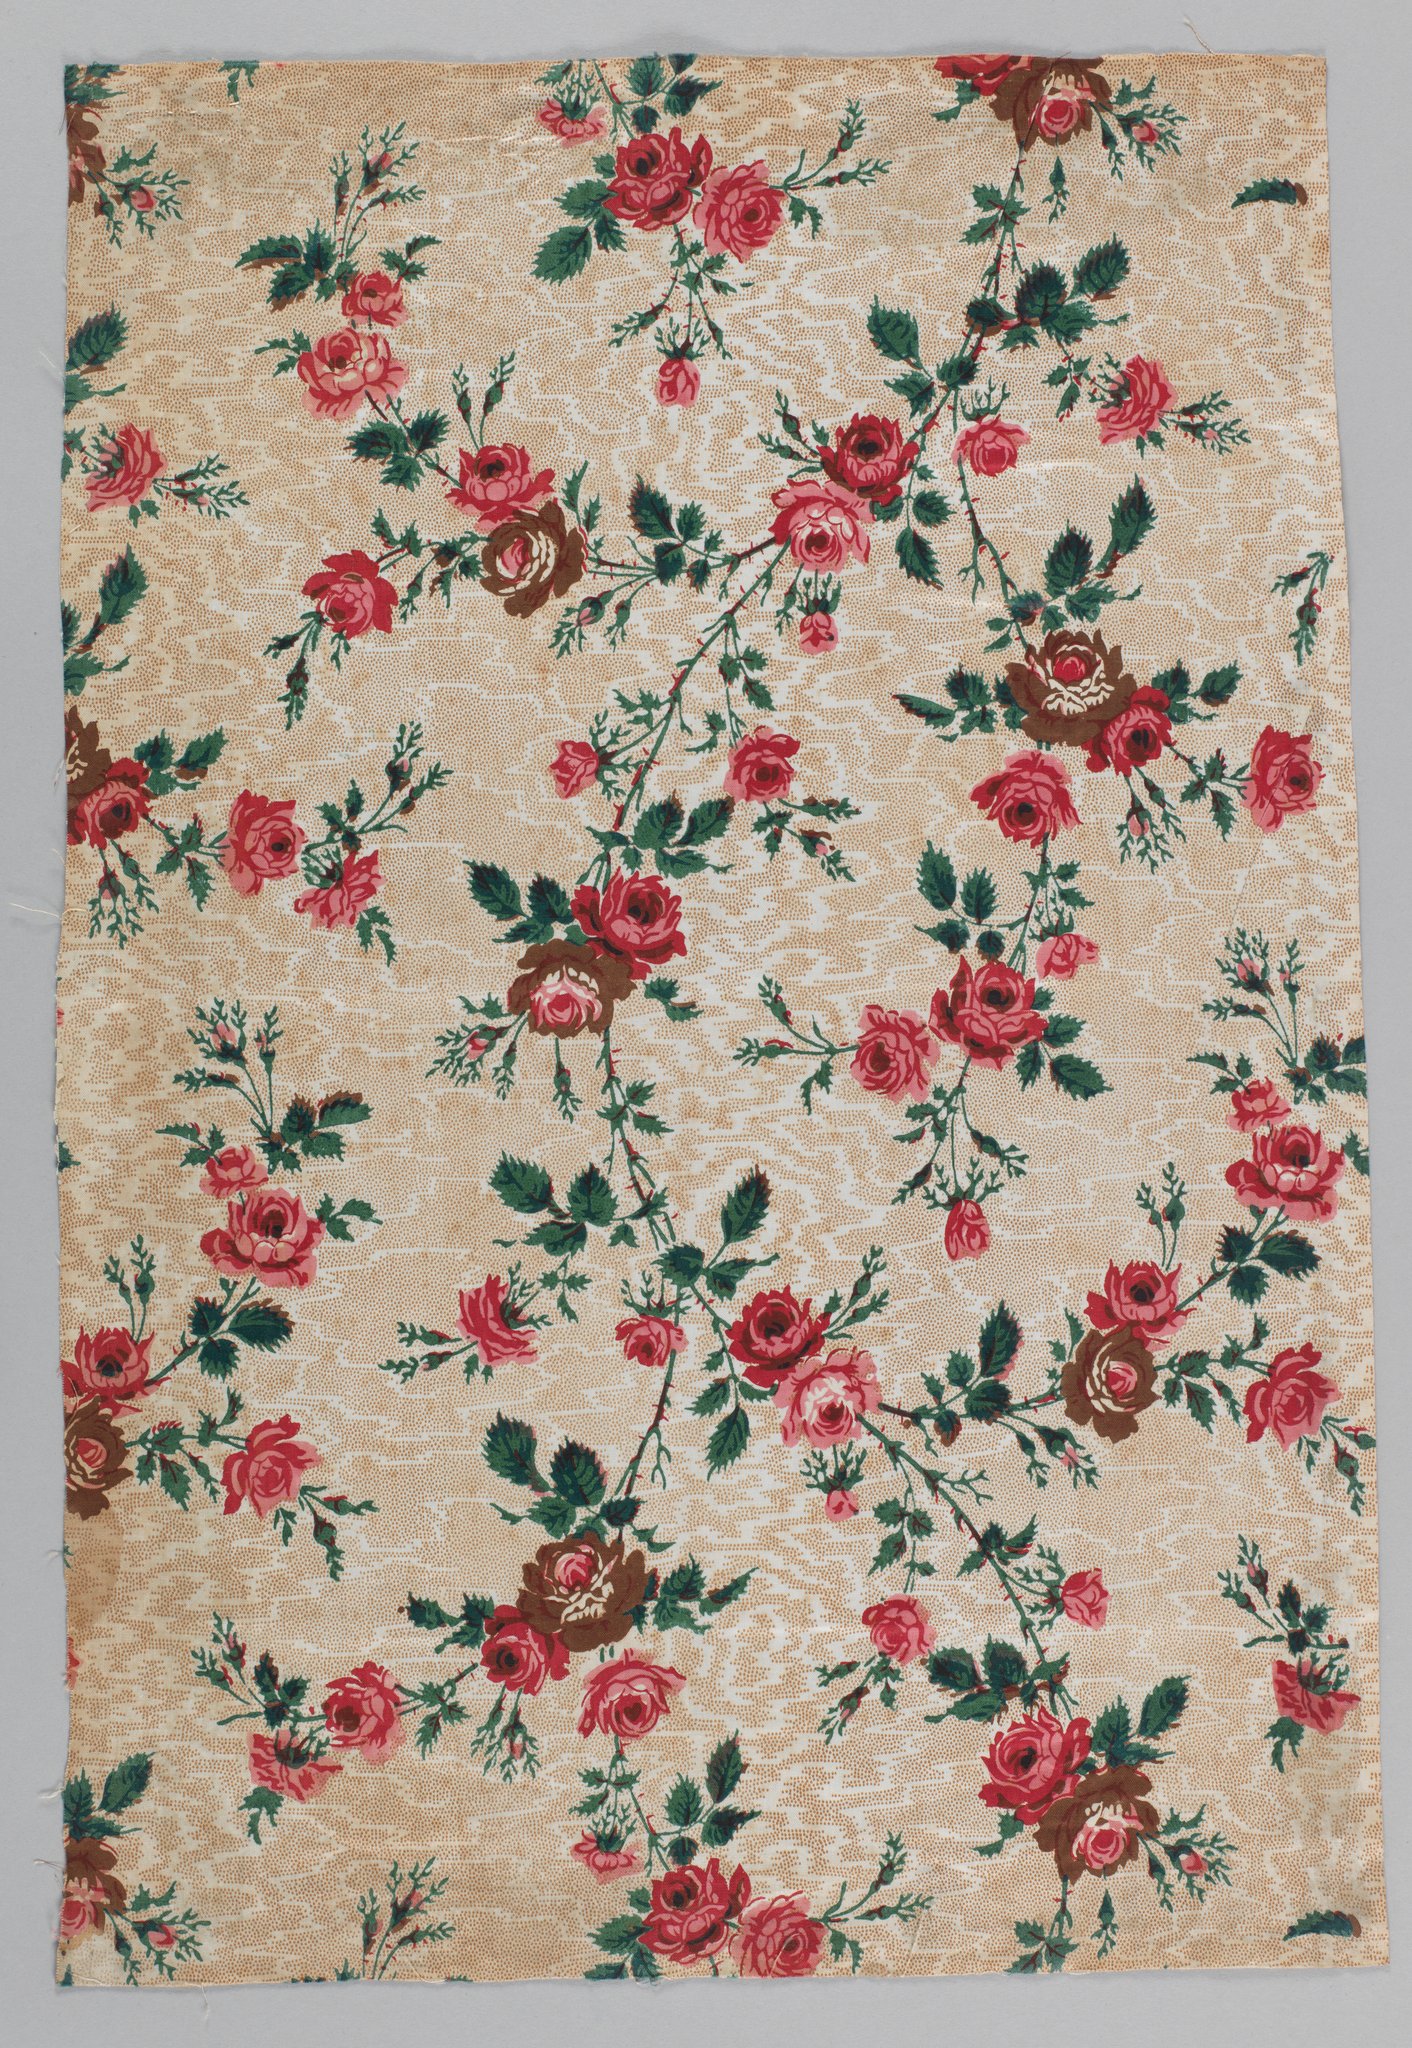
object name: piece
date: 1801-1900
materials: cotton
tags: flowers